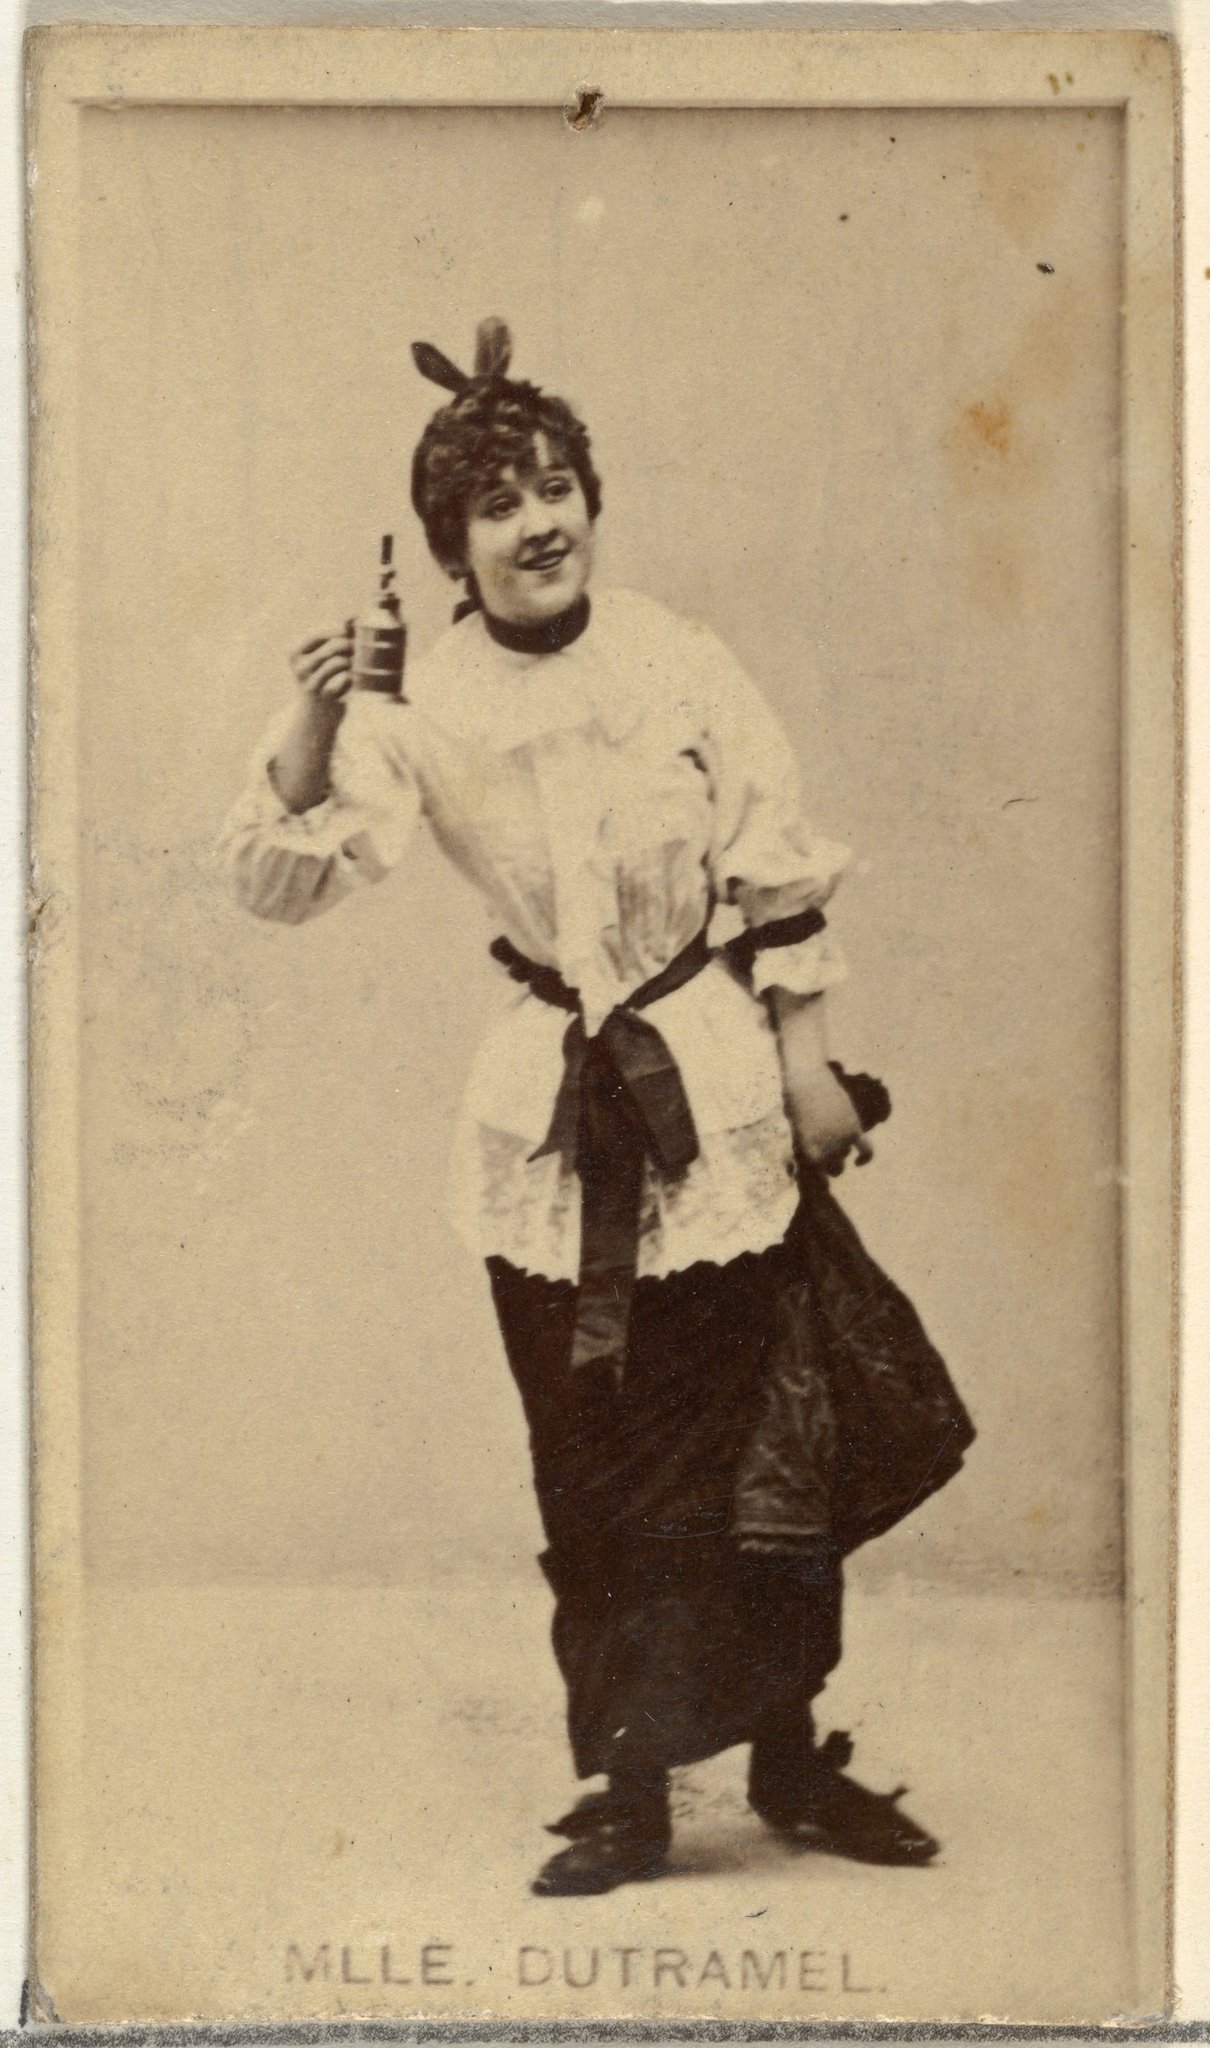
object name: photograph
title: Mlle. Dutramel, from the Actors and Actresses series (N145-8) issued by Duke Sons & Co. to promote Duke Cigarettes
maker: w. duke, sons & co.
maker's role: publisher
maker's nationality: american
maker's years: 1870-1920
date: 1891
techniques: albumen silver print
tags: portraits,women,actresses